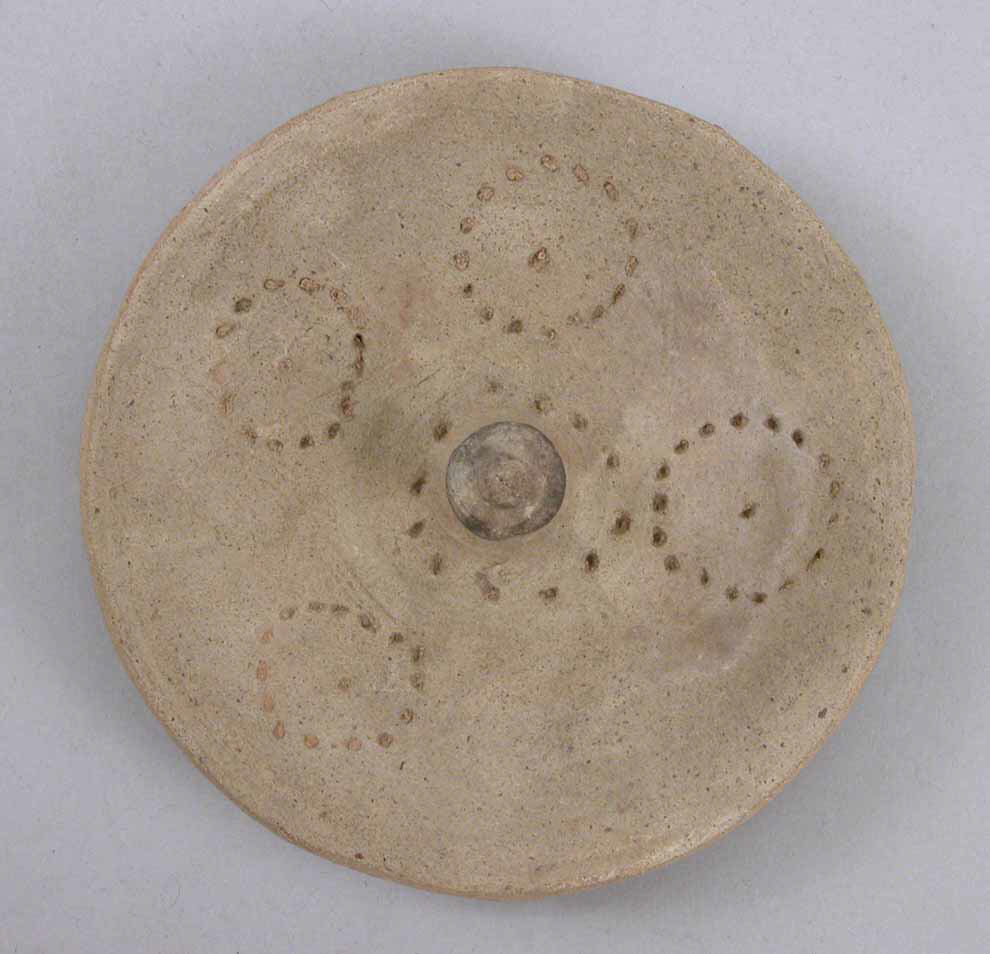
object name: lid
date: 801-1000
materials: earthenware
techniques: incising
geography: iran